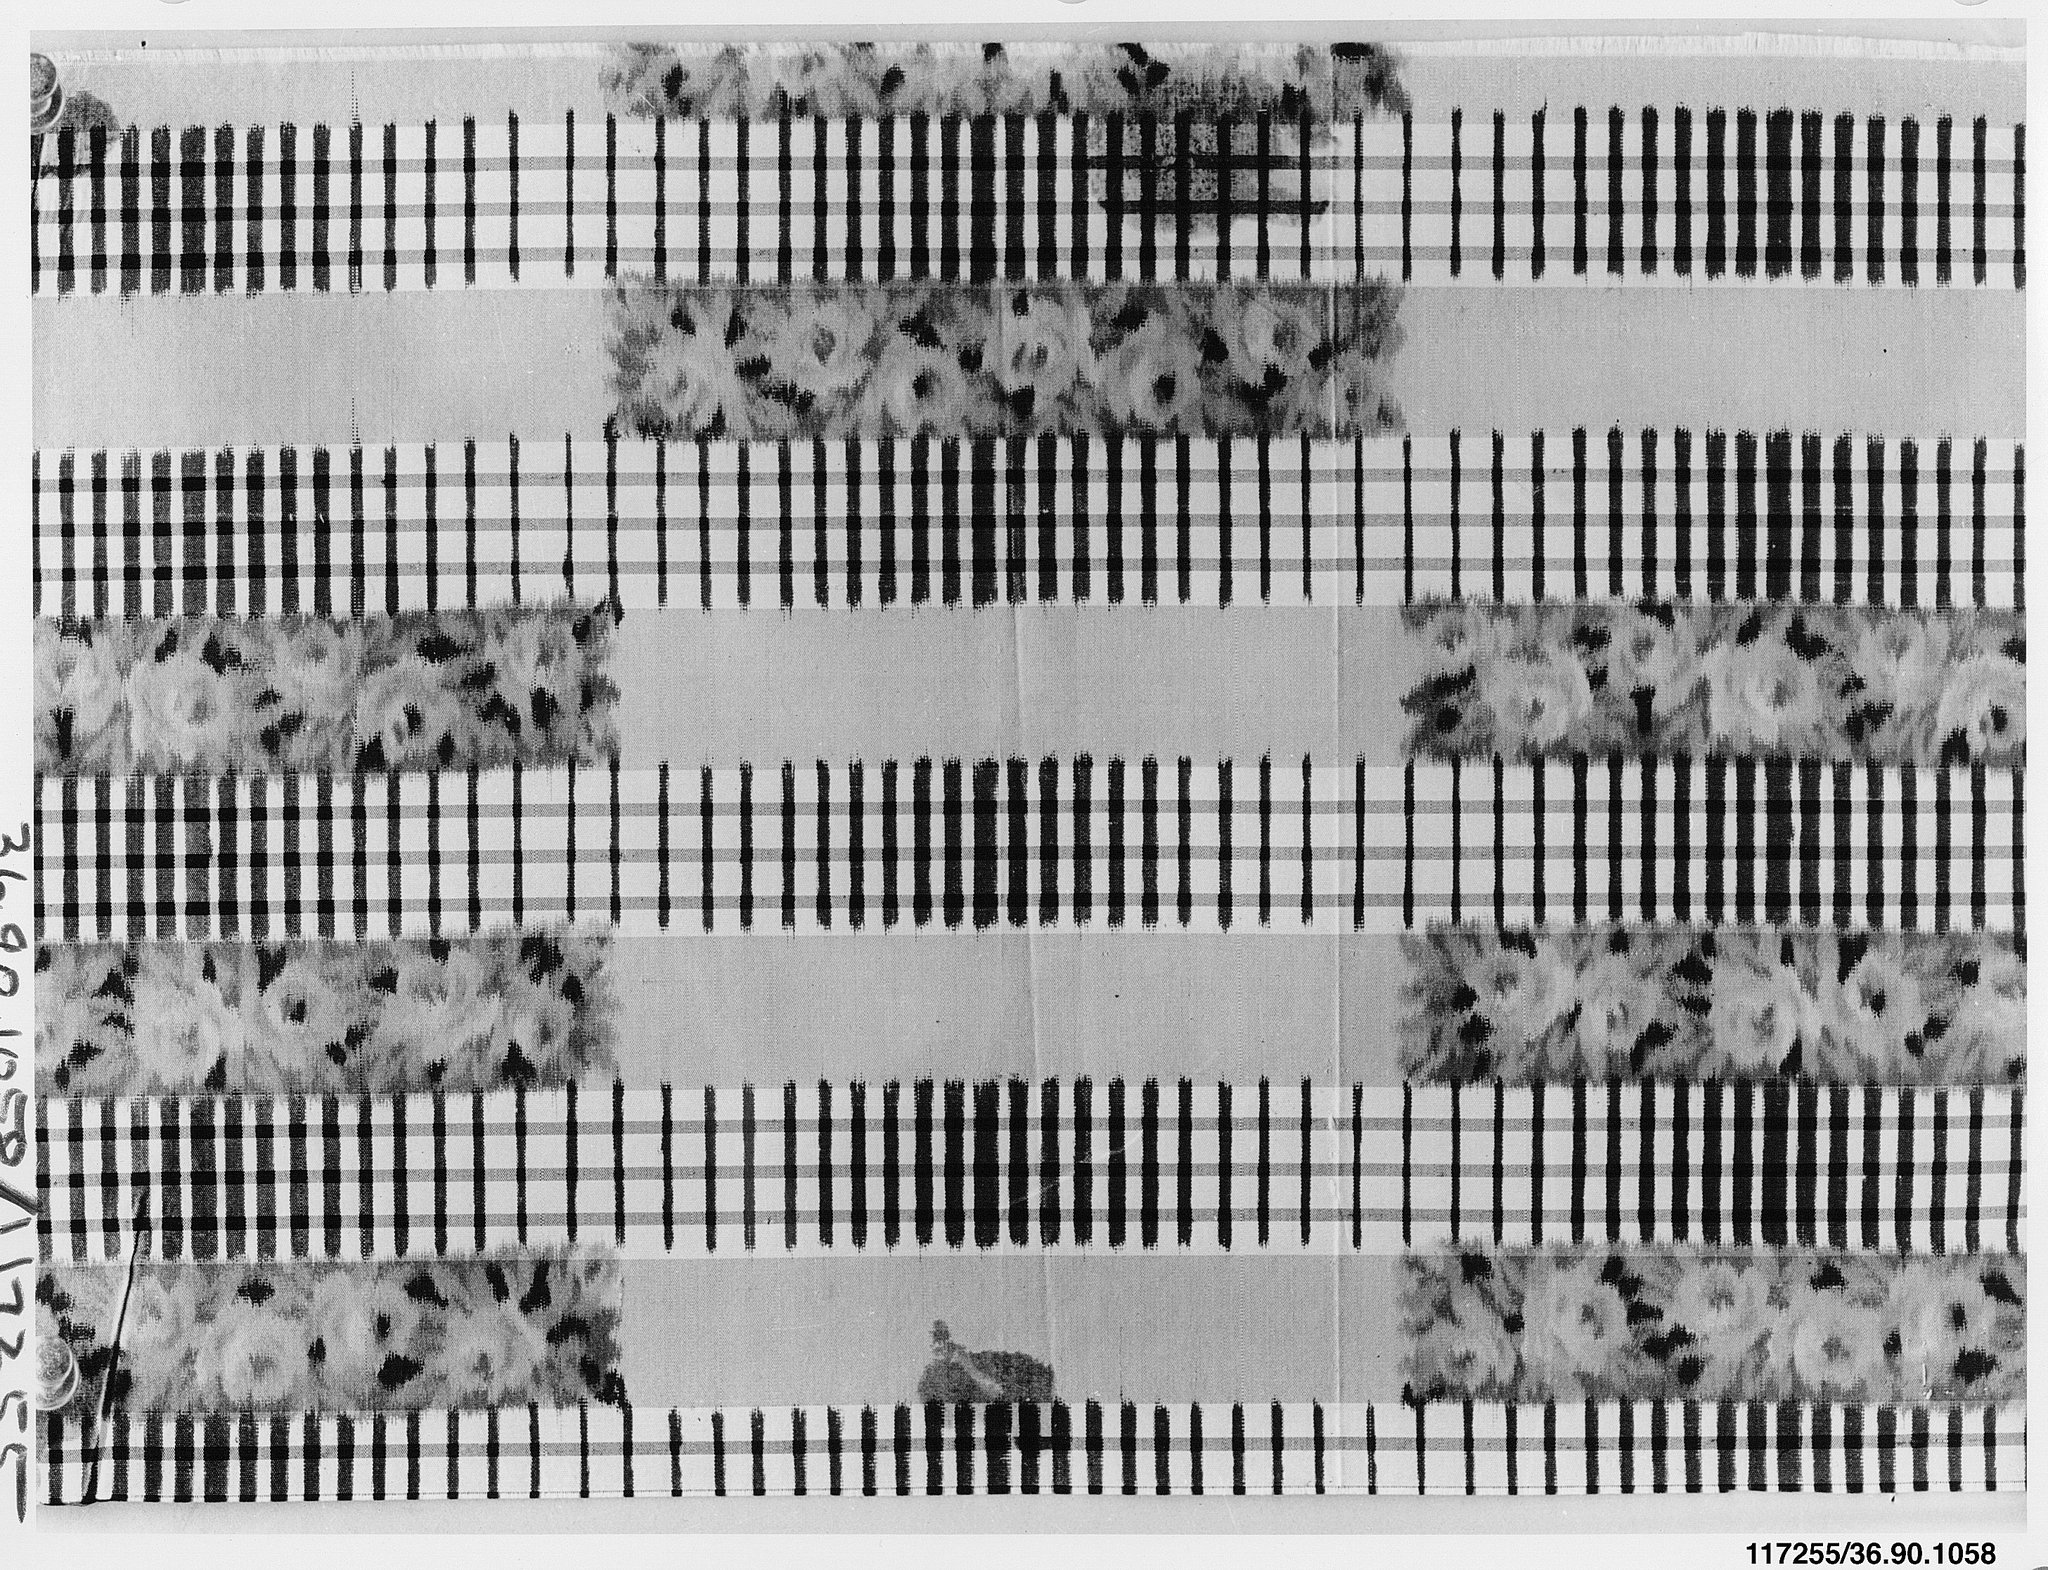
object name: piece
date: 1801-1900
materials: silk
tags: flowers